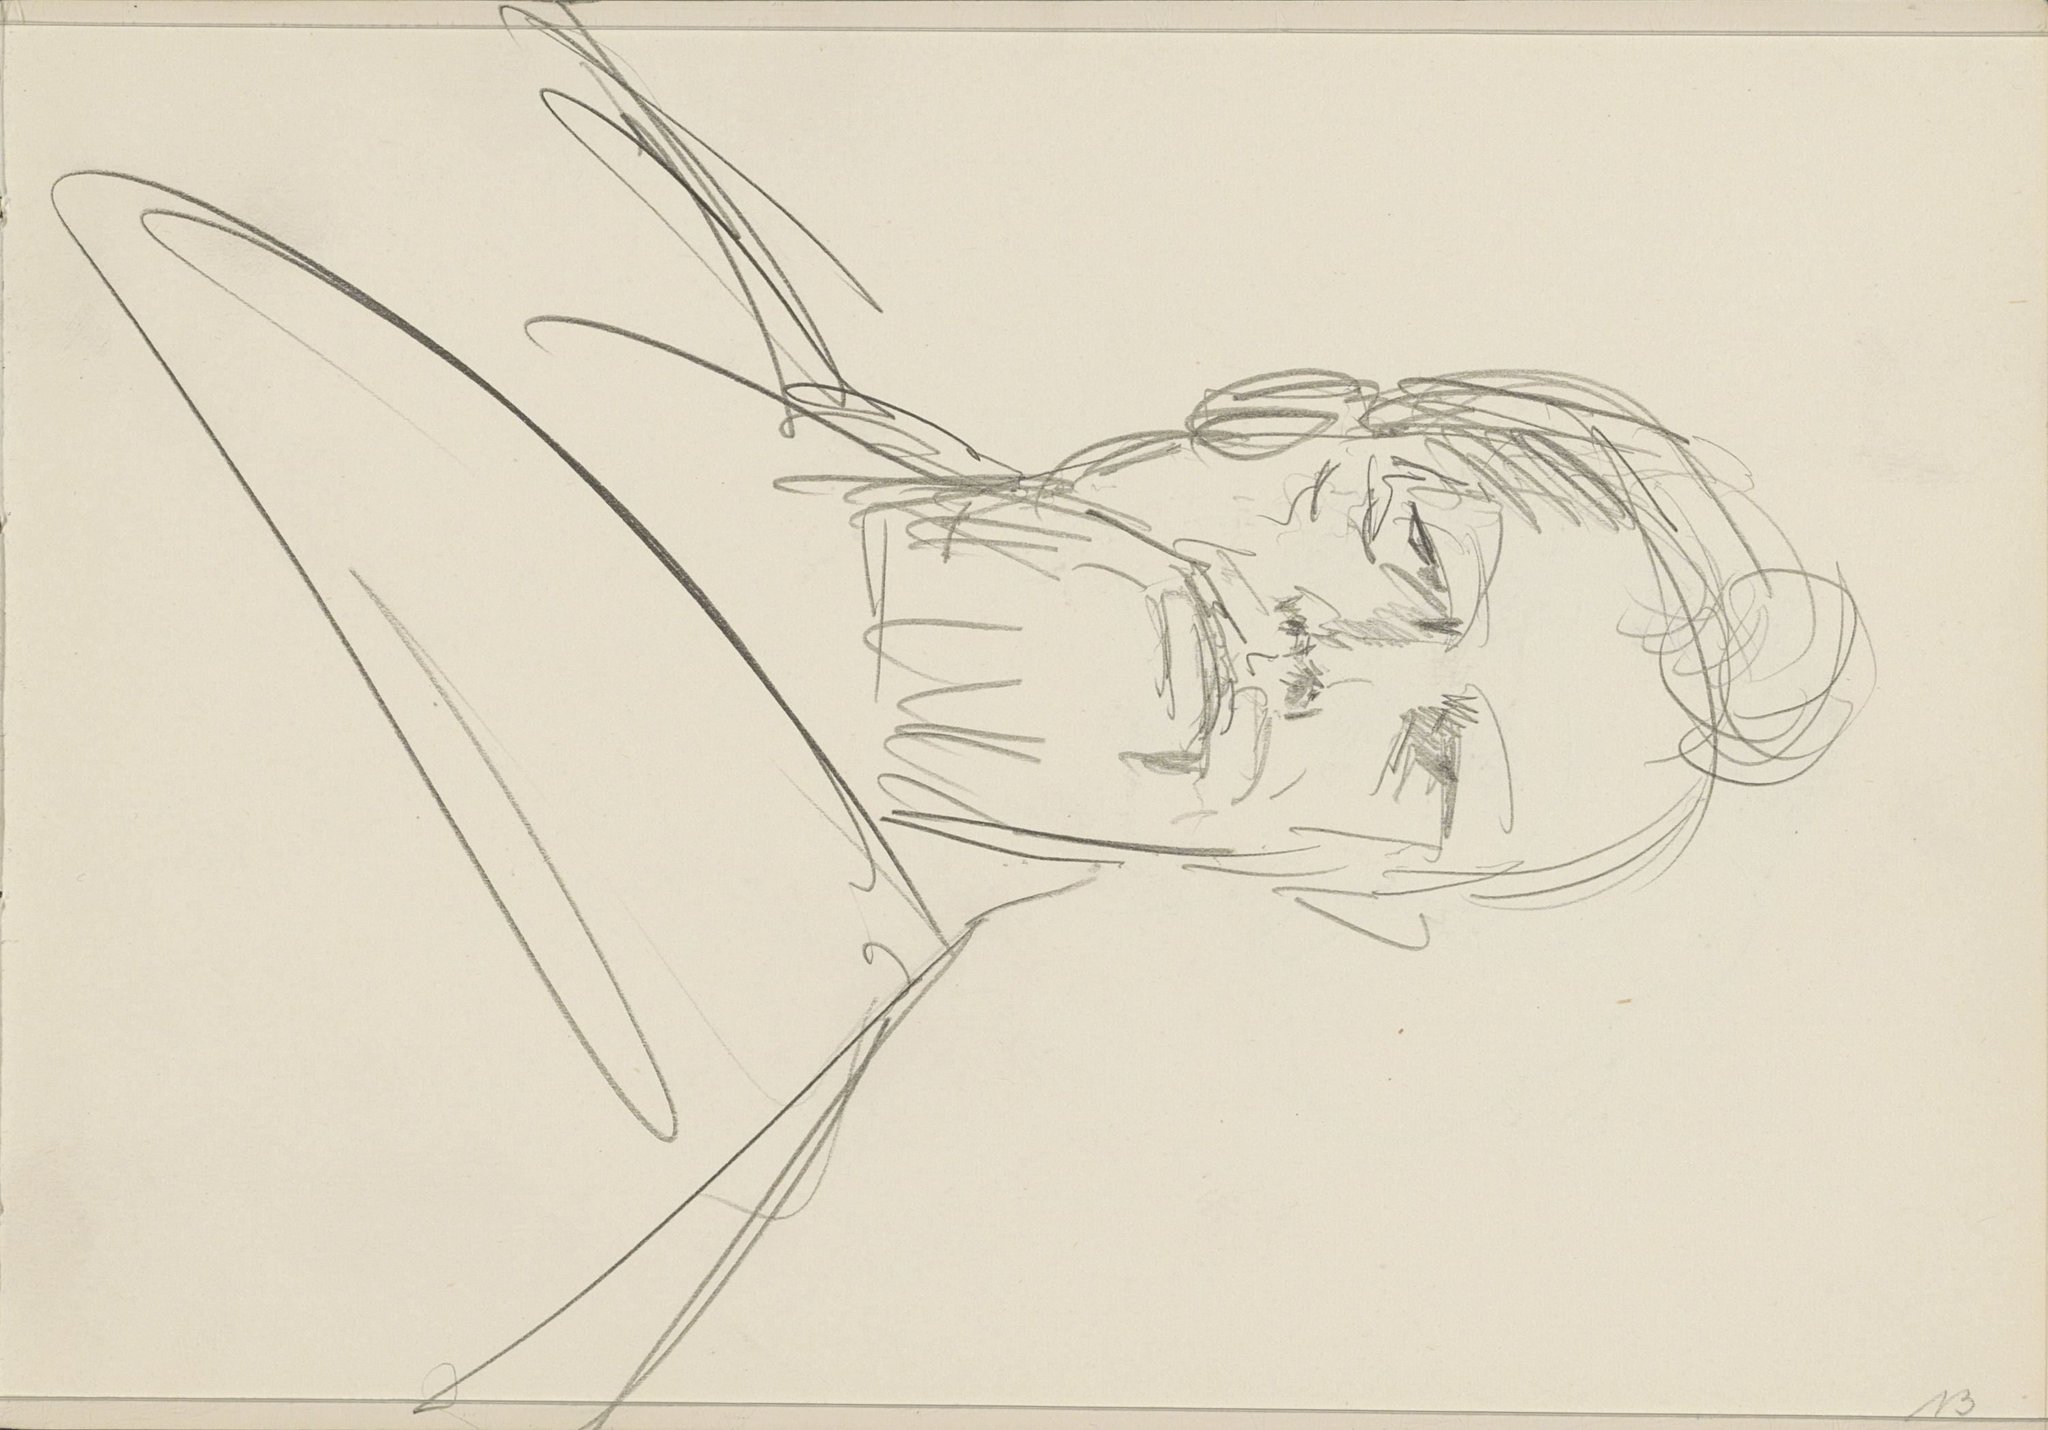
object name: sketchbook leaf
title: Portret van een onbekende man met baard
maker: isaac israels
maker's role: draughtsman, painter, print maker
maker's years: 1865-1934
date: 1915-1934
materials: paper, pencil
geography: the hague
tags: anonymous historical person portrayed alone, beard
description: Blad 13 recto uit schetsboek XXV met 23 bladen.